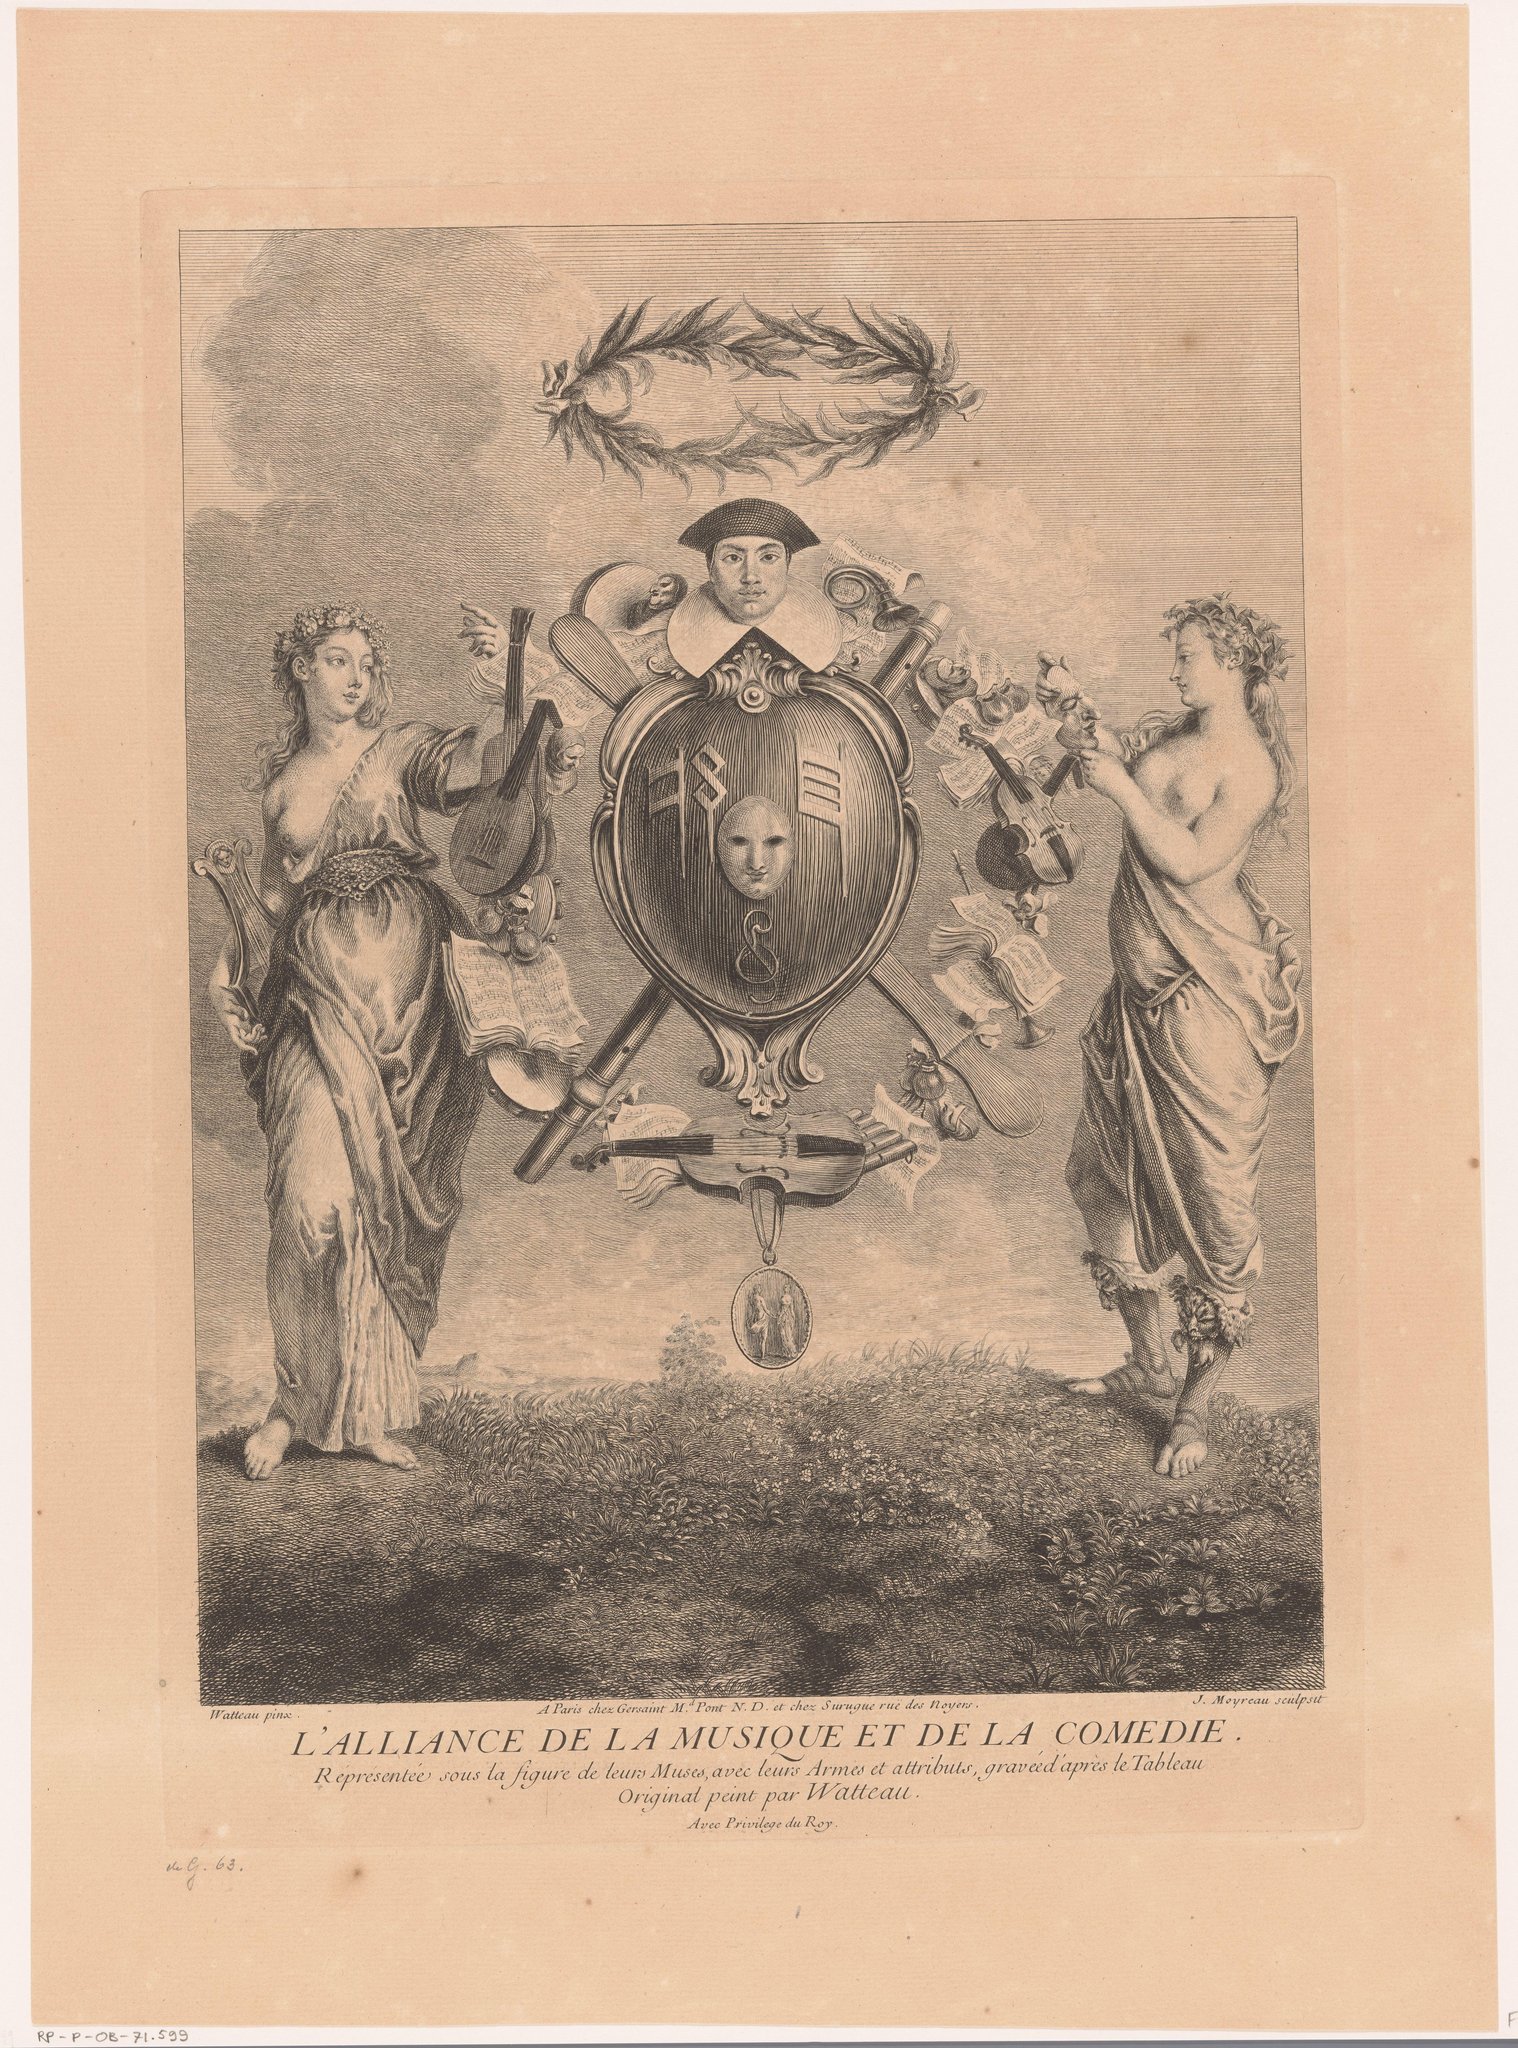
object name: print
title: L'oeuvre d'Antoine Watteau, peintre du roy en son Academie roïale de peinture et sculpture (...)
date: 1726-1735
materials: paper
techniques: engraving, etching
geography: paris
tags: music, thalia (one of the muses); 'talia' (ripa), erato (one of the muses); 'erato' (ripa), comedy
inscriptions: collector's mark: Lugt 2228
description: Maakt deel uit van een serie van 271 platen naar schilderijen door Watteau, verdeeld over drie delen, gecoördineerd door Jean de Jullienne en uitgegeven in Parijs tussen 1726 en 1735. Sommige platen werden reeds tijdens Watteau's leven gemaakt. Dit betreft plaat 39.